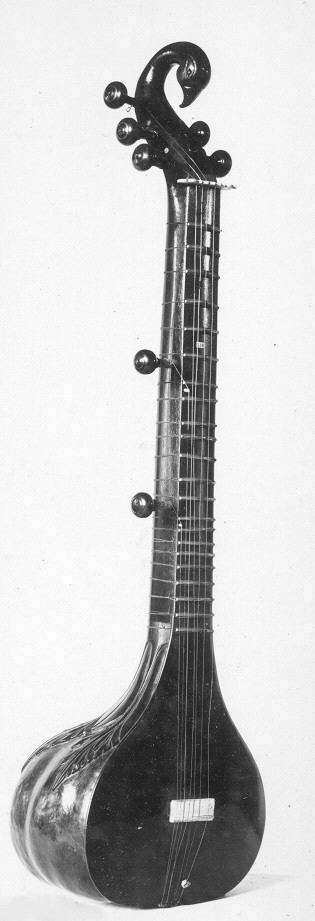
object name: kunjerre vina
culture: indian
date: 1801-1900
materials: wood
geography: india